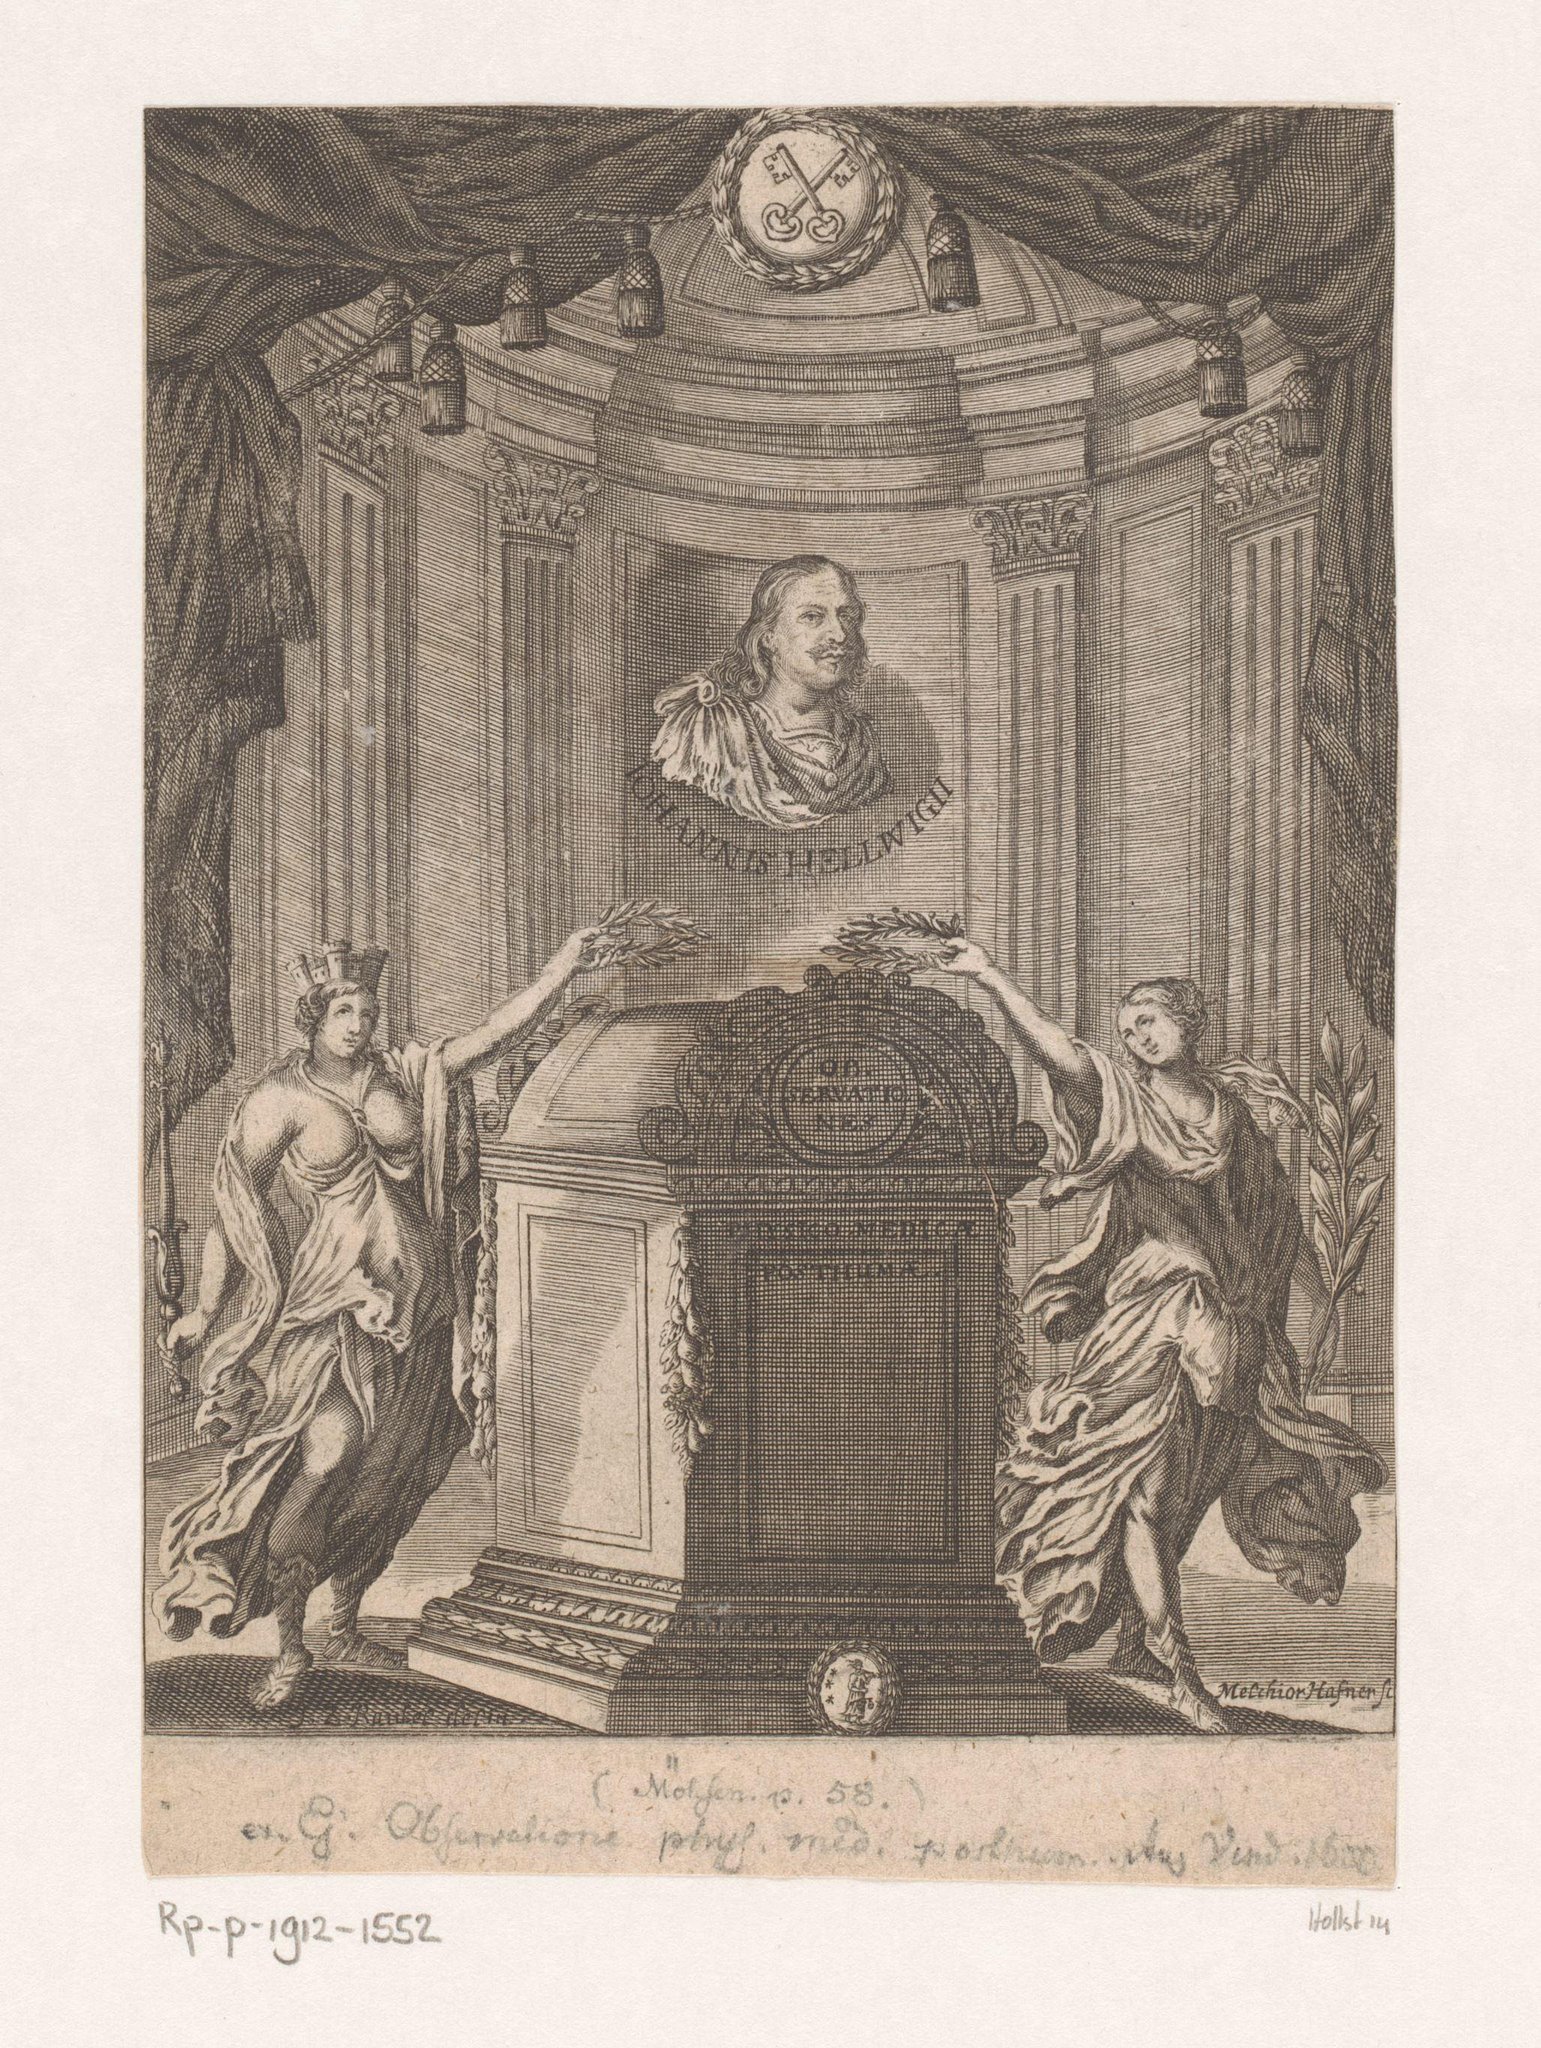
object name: print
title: Allegorische voorstelling rond het grafmonument van Johann Hellwig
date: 1674-1704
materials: paper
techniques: engraving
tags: johann hellwig, city-crown, mural crown, historical persons, physician, doctor, crowning with laurel, grave-building, monumental tomb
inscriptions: collector's mark: Lugt 2228